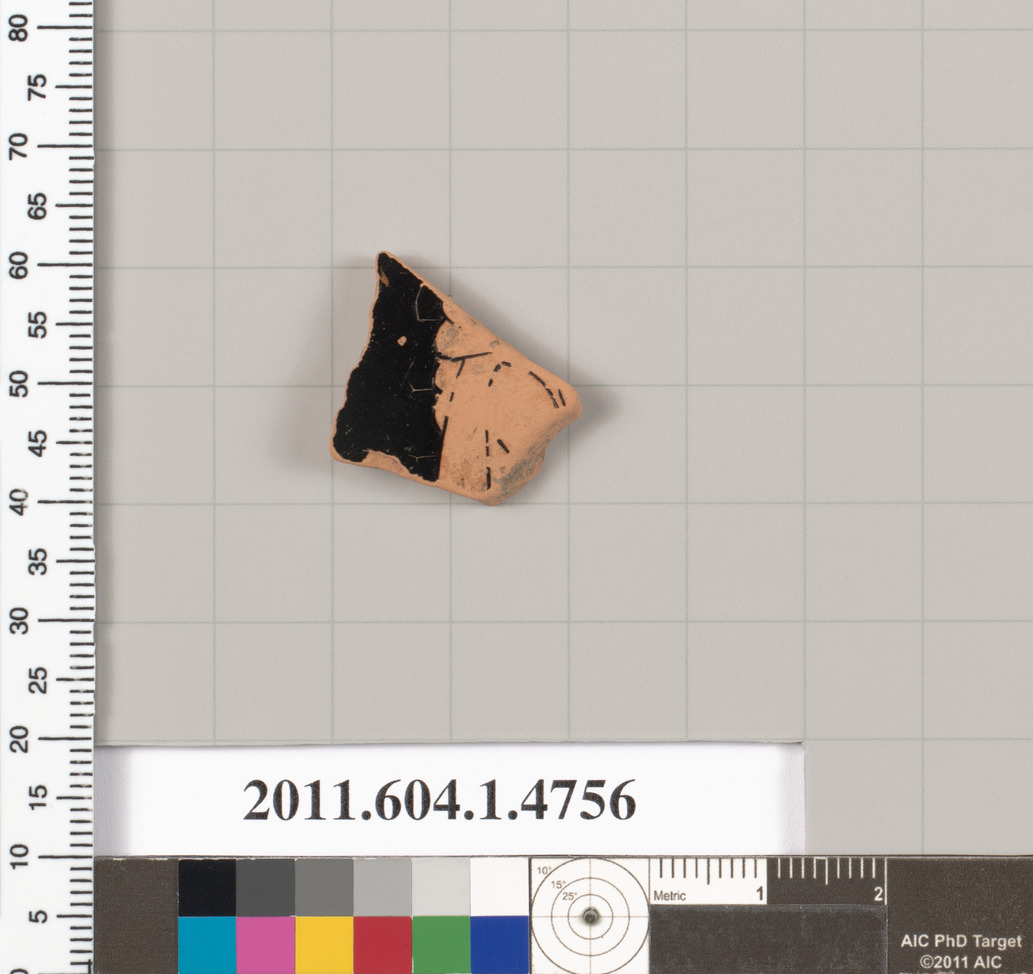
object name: kylix fragment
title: Terracotta fragment of a kylix (drinking cup)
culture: greek, attic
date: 490-470 BCE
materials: terracotta